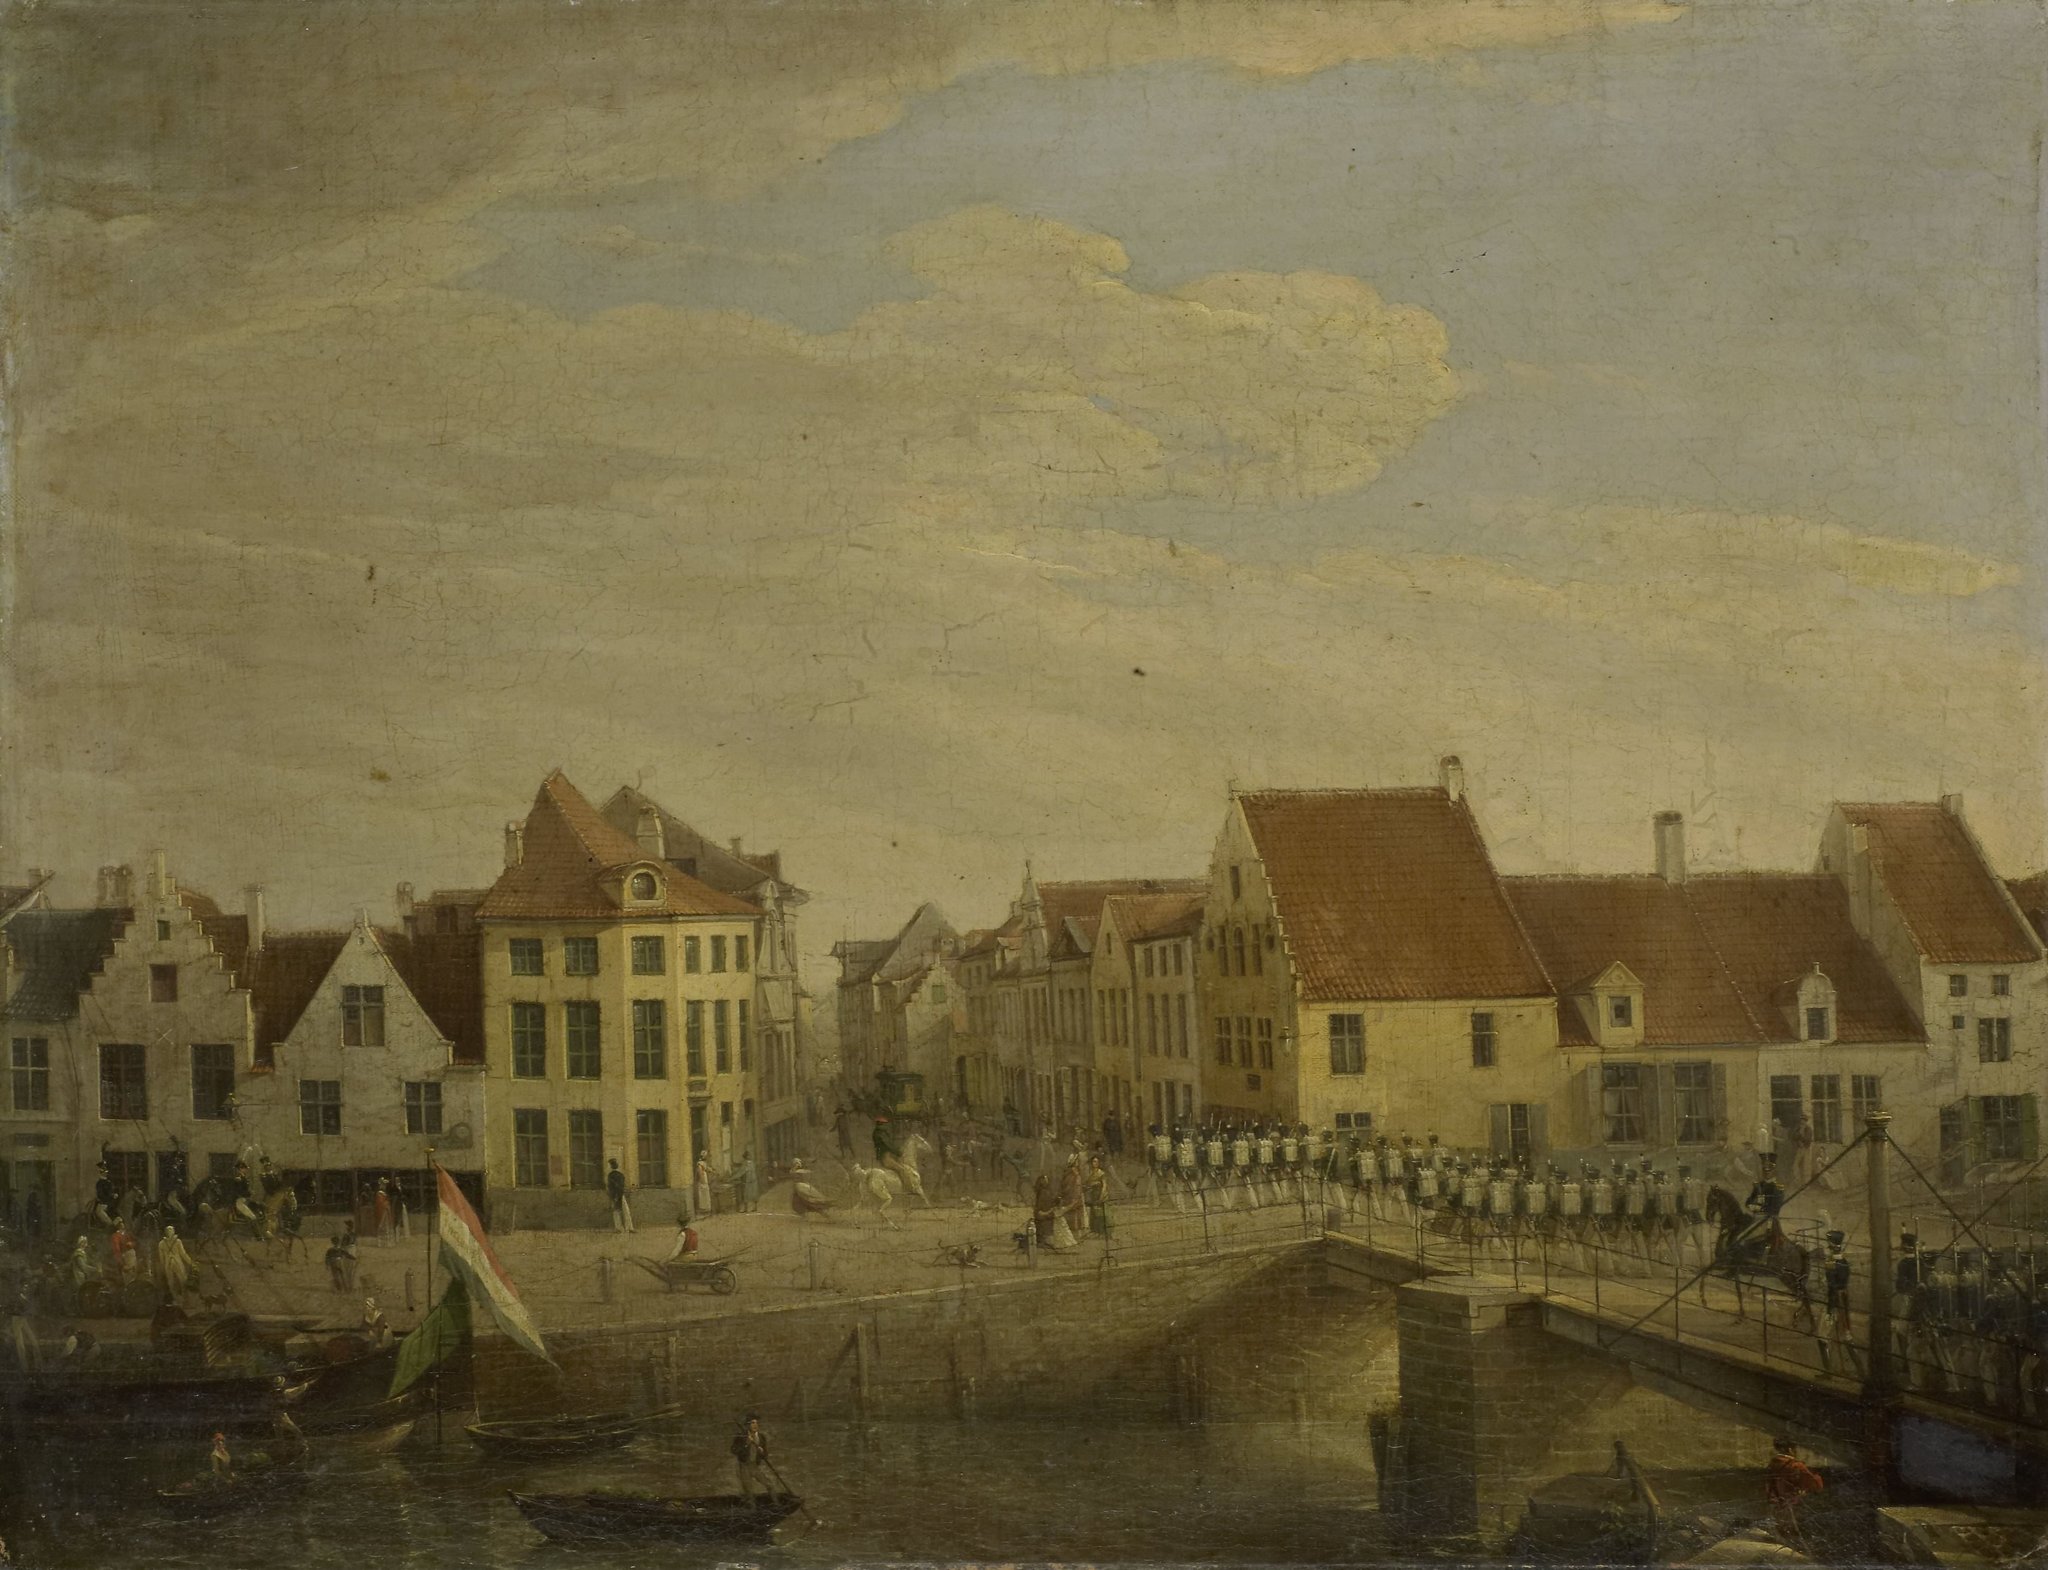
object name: painting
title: Dutch Troops passing through the Fortress of Dendermonde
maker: petrus groenia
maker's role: painter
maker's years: 1769-1844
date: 1820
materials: canvas, oil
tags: troop movements, transportation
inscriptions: signature: ‘Petrus Groenia’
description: Hollandse troepen trekken door de vestingstad Dendermonde. Rechts marcheren de soldaten over de Bogaerdbrug en gaan in de richting van de Veerstraat. Links de Scheldestraat (thans de Franz Courtensstraat) met de kade, waaraan een boot met een Hollandse vlag ligt gemeerd. Op de kade officieren te paard. Rechts een viertal huizen van de Kasteelstraat.